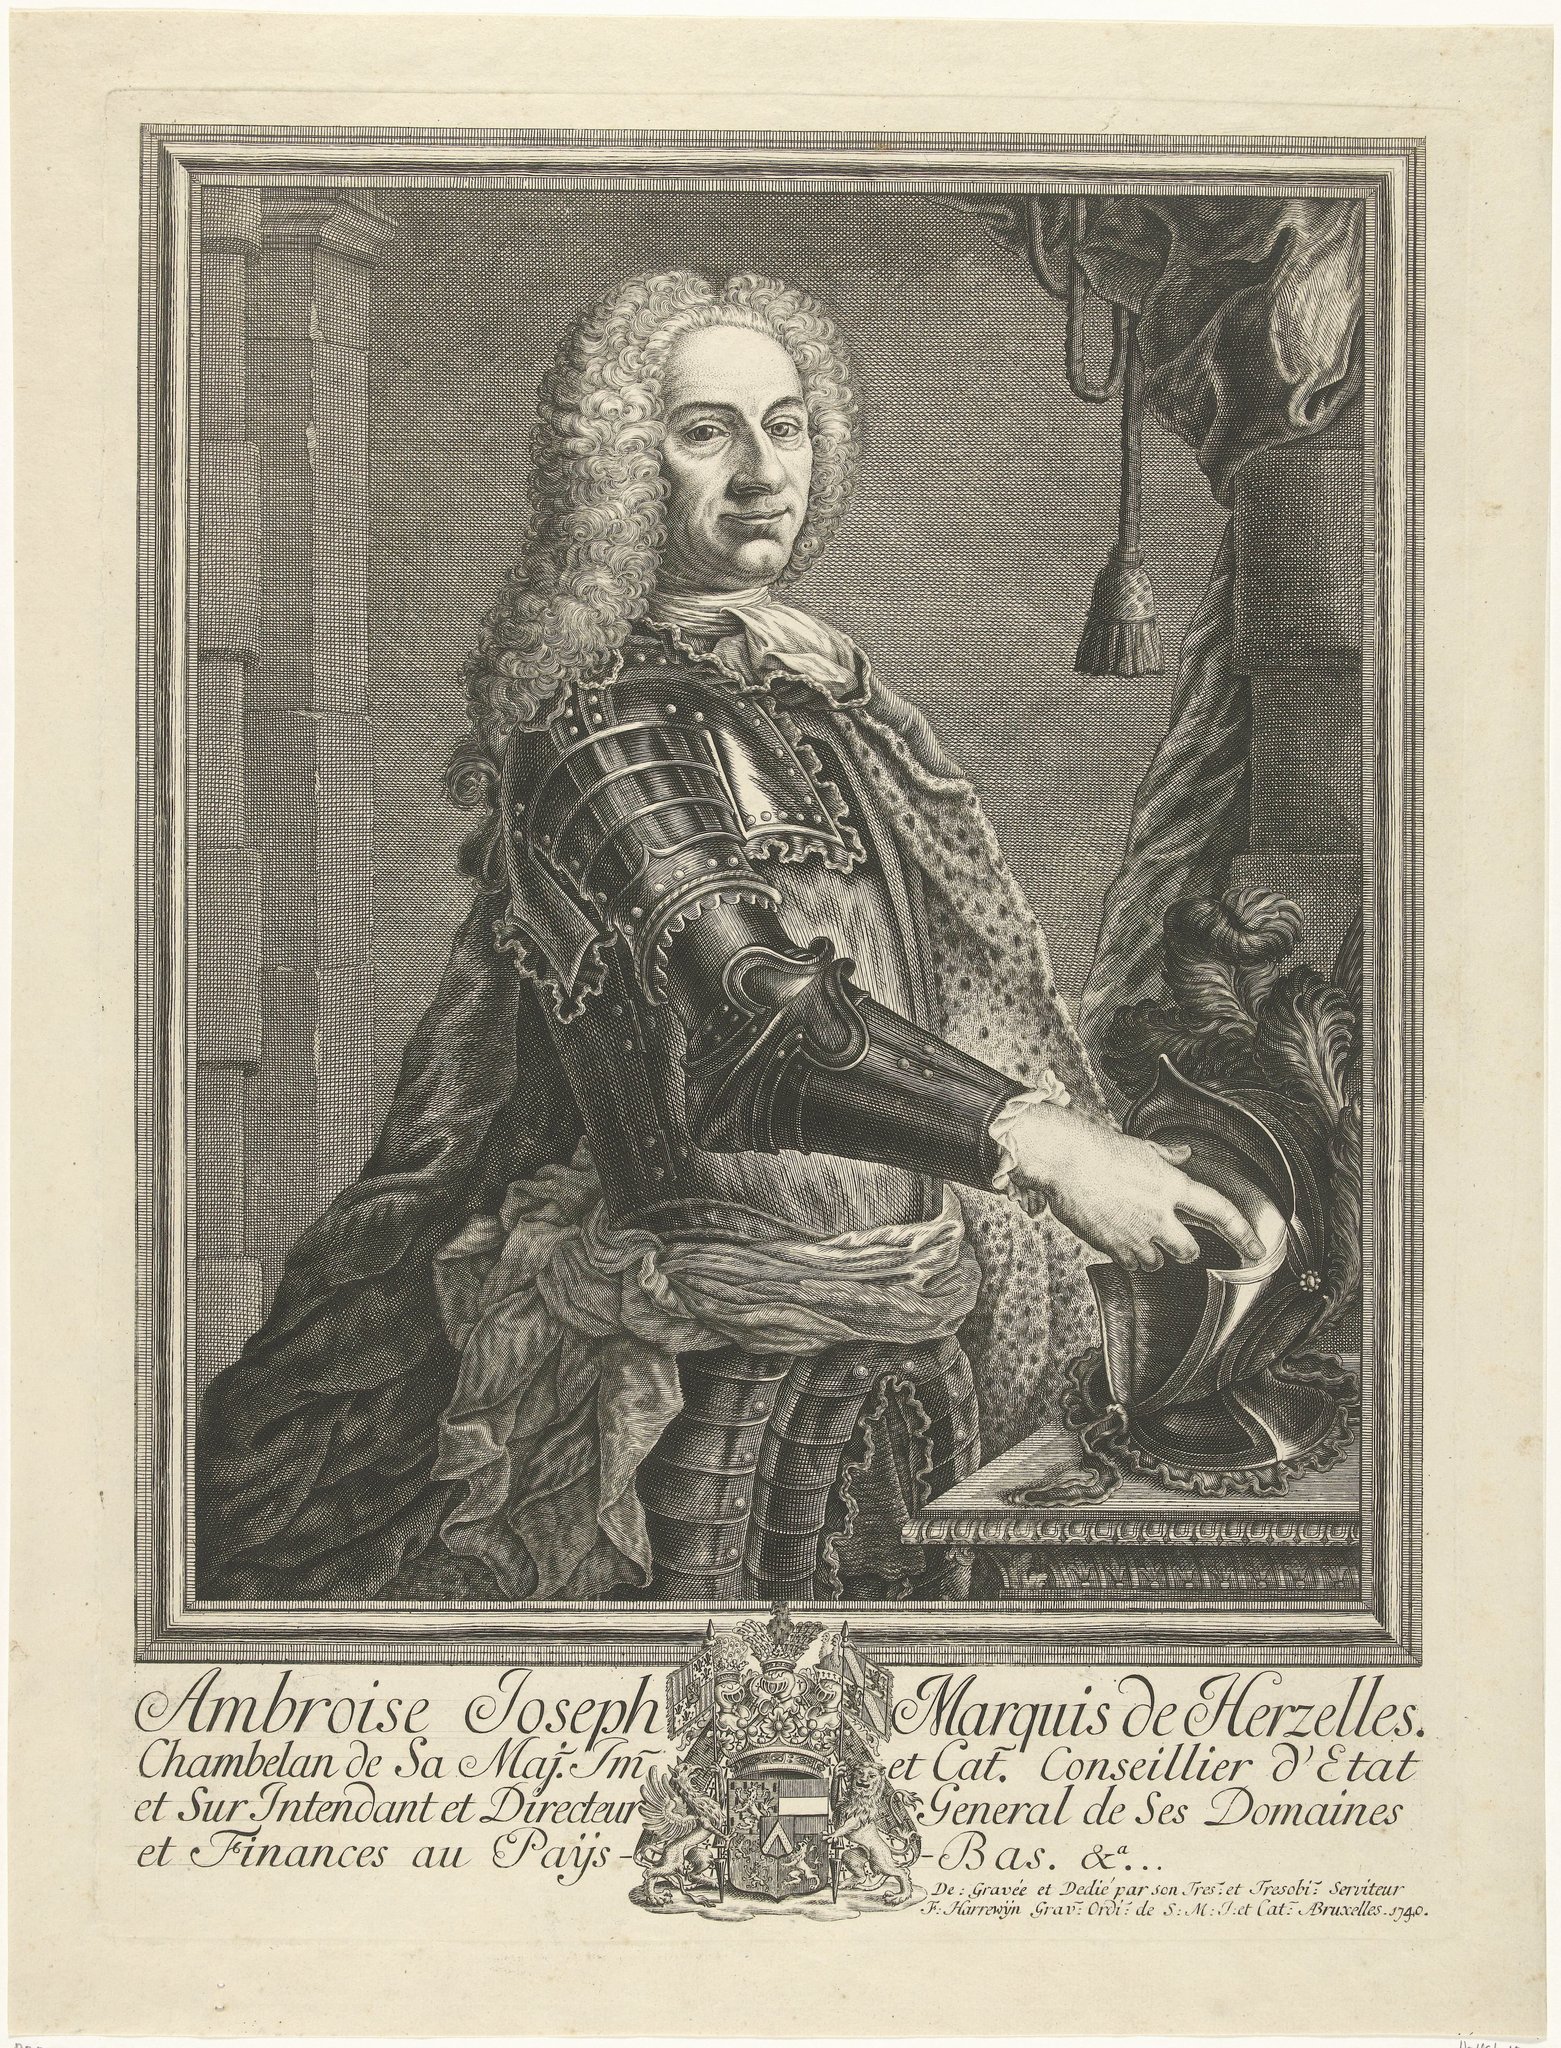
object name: print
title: Portret van Ambroise-Joseph, marquis de Herzelles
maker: françois harrewijn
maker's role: print maker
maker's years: 1700-1764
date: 1740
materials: paper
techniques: engraving, etching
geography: brussels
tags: helmet, armour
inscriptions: collector's mark: Lugt 2228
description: Kniestuk naar rechts van Ambroise-Joseph, marquis de Herzelles, gekleed in een harnas en staand bij een tafel waarop een helm.